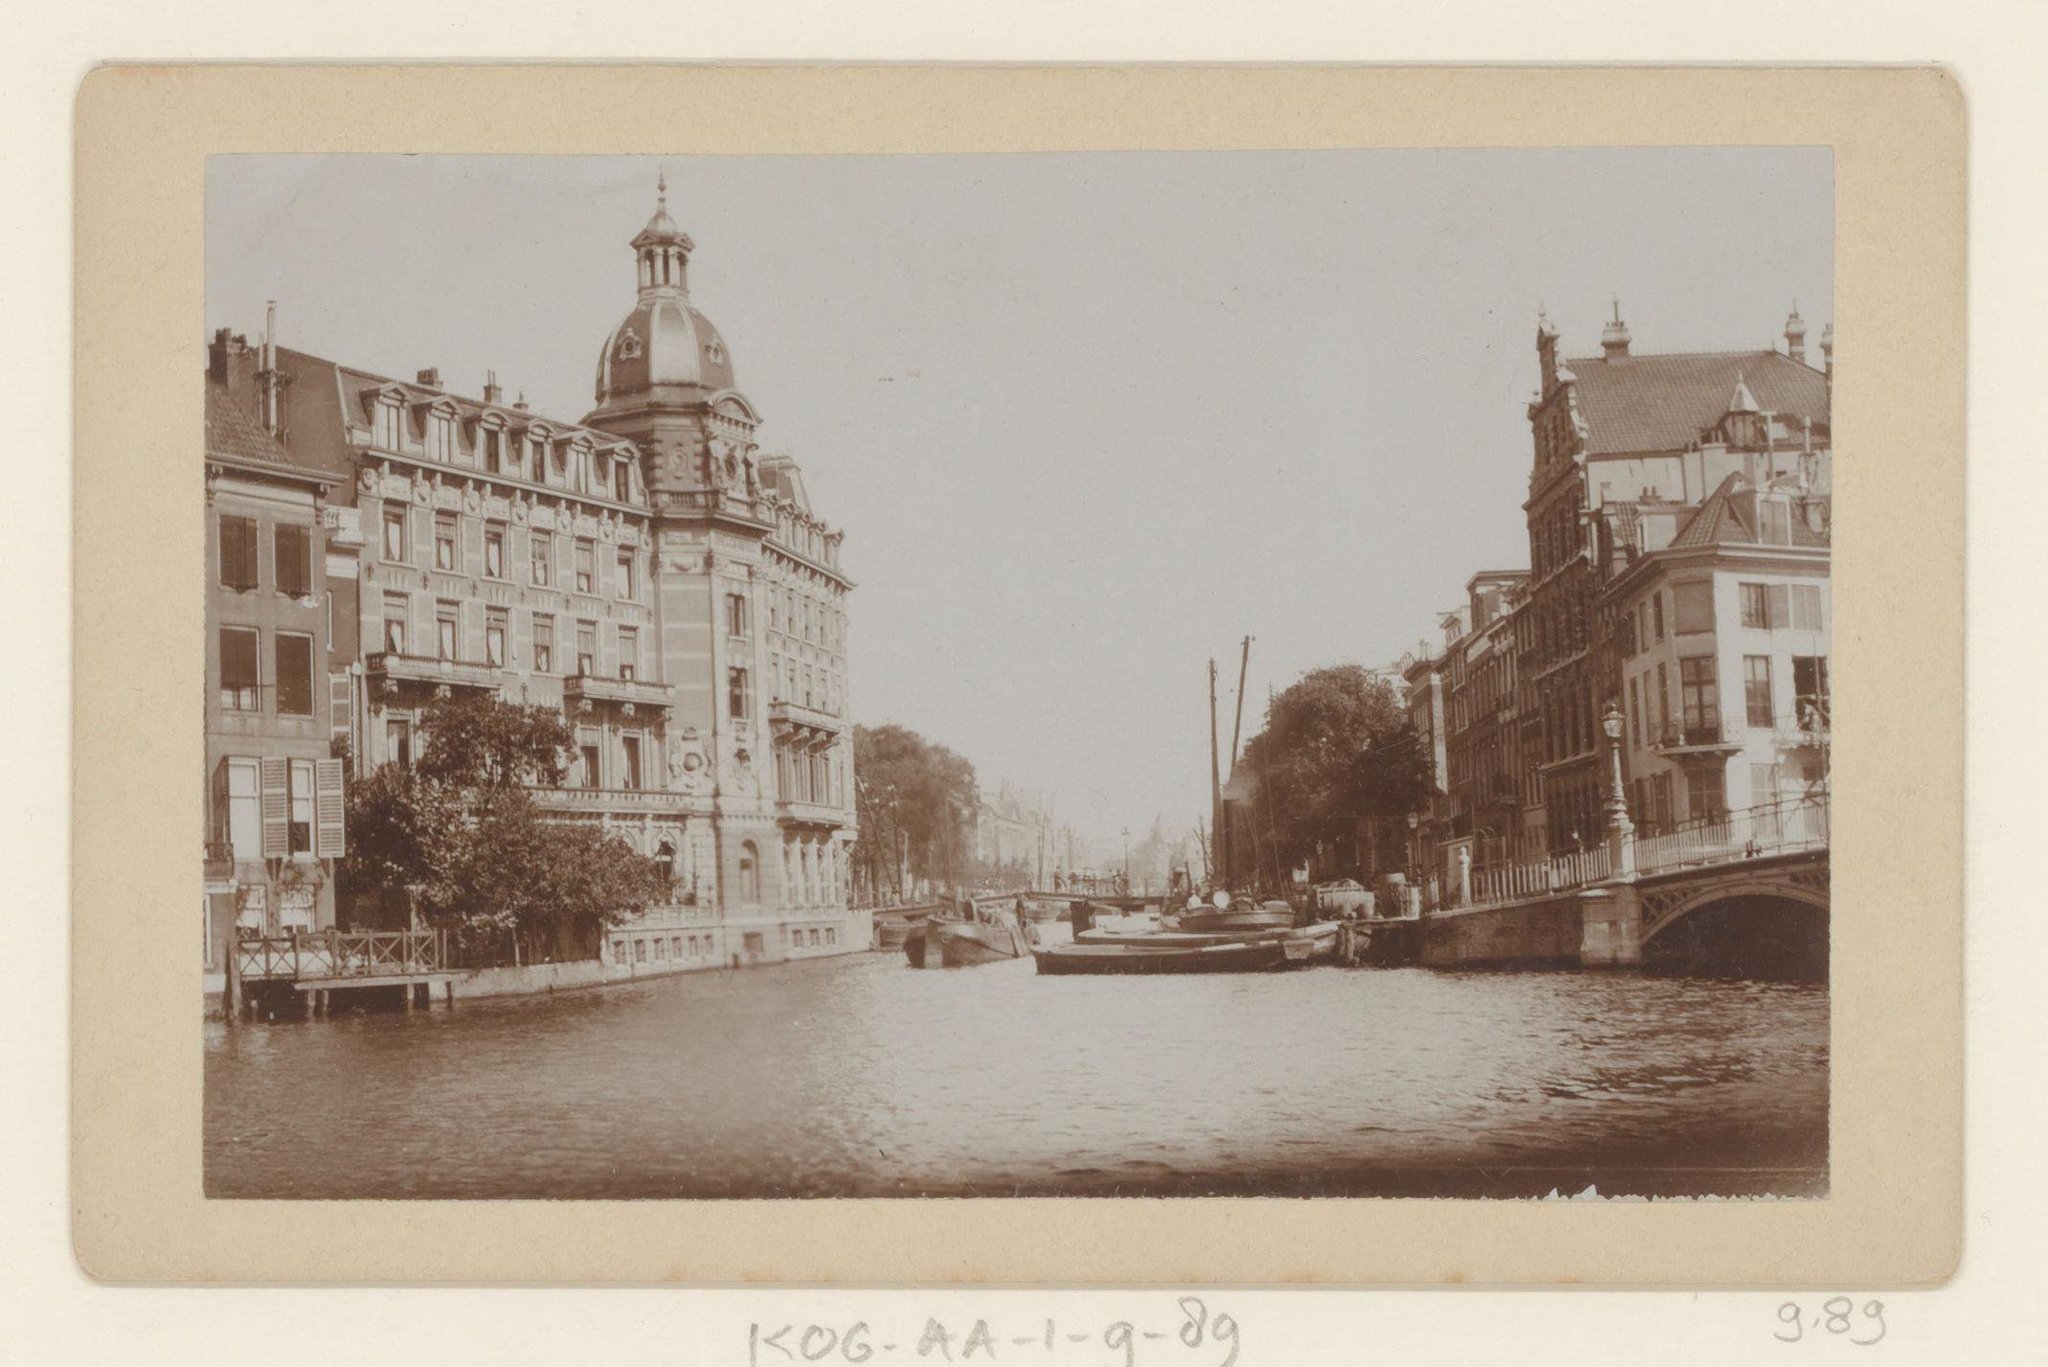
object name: cabinet photograph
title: Gezicht op het Doelenhotel aan de Kloveniersburgwal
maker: Anonymous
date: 1883-1940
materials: paper, cardboard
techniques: collodion silver print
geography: amsterdam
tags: city-view in general; 'veduta', canal, hôtel, i.e. small palace in city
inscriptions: inscription: ‘no 43 Doelen Hotel / Kloveniersburgwal.’, collector's mark: ‘9.89’ Lugt 1641b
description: Onderwerpsrubriek binnen de Atlas Amsterdam: Kadijksplein, Karthuizerkerkhof, Kattegat, Kattenburg, Kapelsteeg O.Z., Enge Kerksteeg, Kerkstraat, Kinkerstraat, Kolk O.Z., Koningsplein, Kromboomsloot [Krom Boomssloot], Kostverlorenkade, Kwakersdwarspad, Kalverstraat, Keizersgracht (v.d. Brouwersgracht – Amstel), Klerensloot (Gedempte), Klimopstraat, Kloveniersburgwal, Kraansluis.